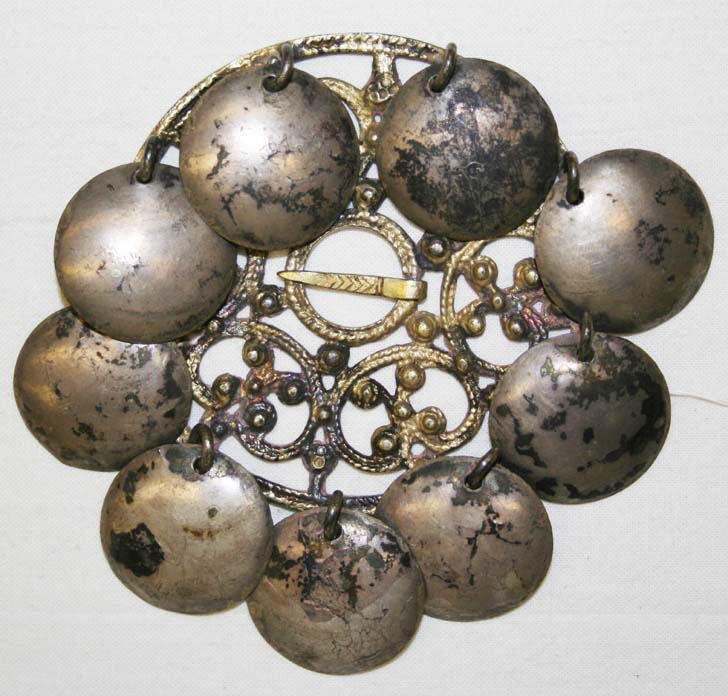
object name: brooch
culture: norwegian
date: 1801-1900